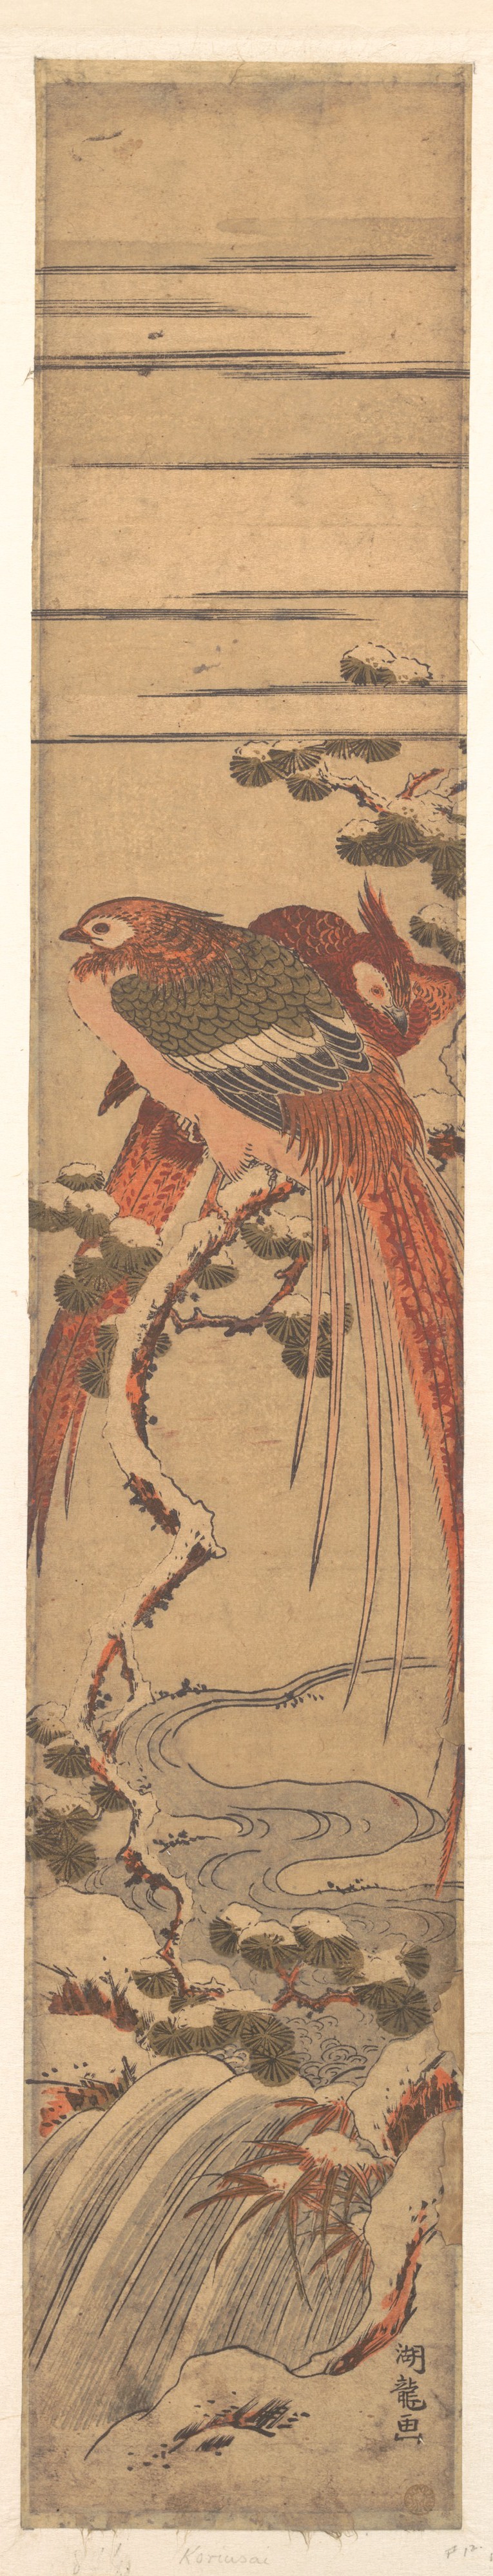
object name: woodblock print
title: Pheasants in the Snow on a Pine Branch over a Waterfall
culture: japanese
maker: isoda koryūsai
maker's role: artist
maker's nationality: japanese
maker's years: 1735-1790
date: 1770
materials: ink, paper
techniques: woodblock print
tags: pheasants,waterfalls,snow